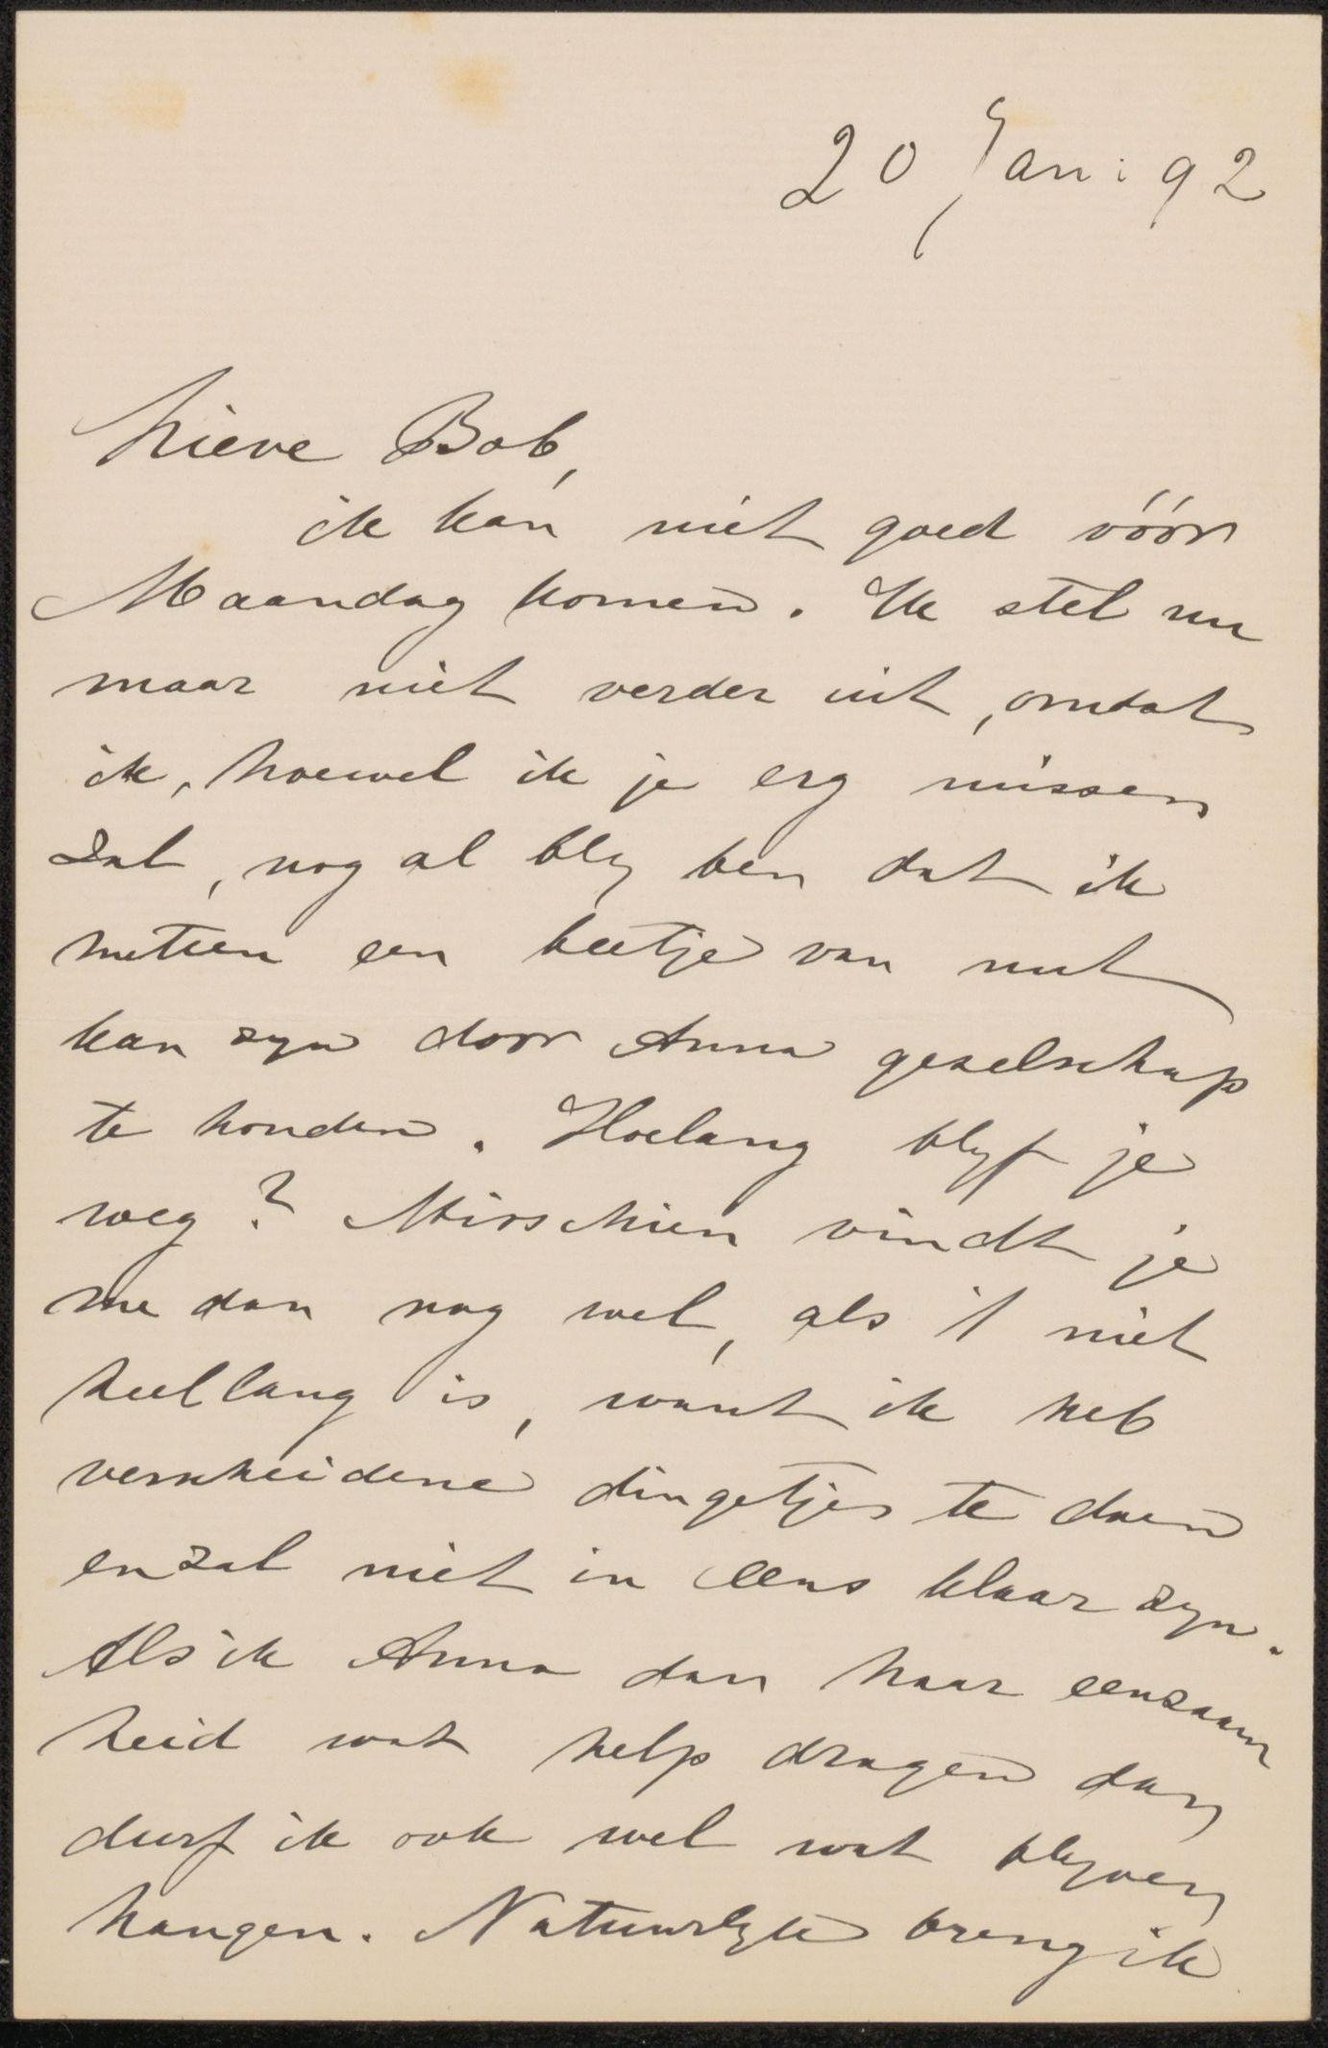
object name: letter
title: Brief aan Jan Veth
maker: wally moes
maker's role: draughtsman, print maker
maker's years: 1856-1918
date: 1874-1918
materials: ink, paper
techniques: pen, writing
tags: dordrecht, painter, print maker, draughtsman, designer, jan veth, artist, anna dorothea dirks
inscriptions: collector's mark: ‘RPK’